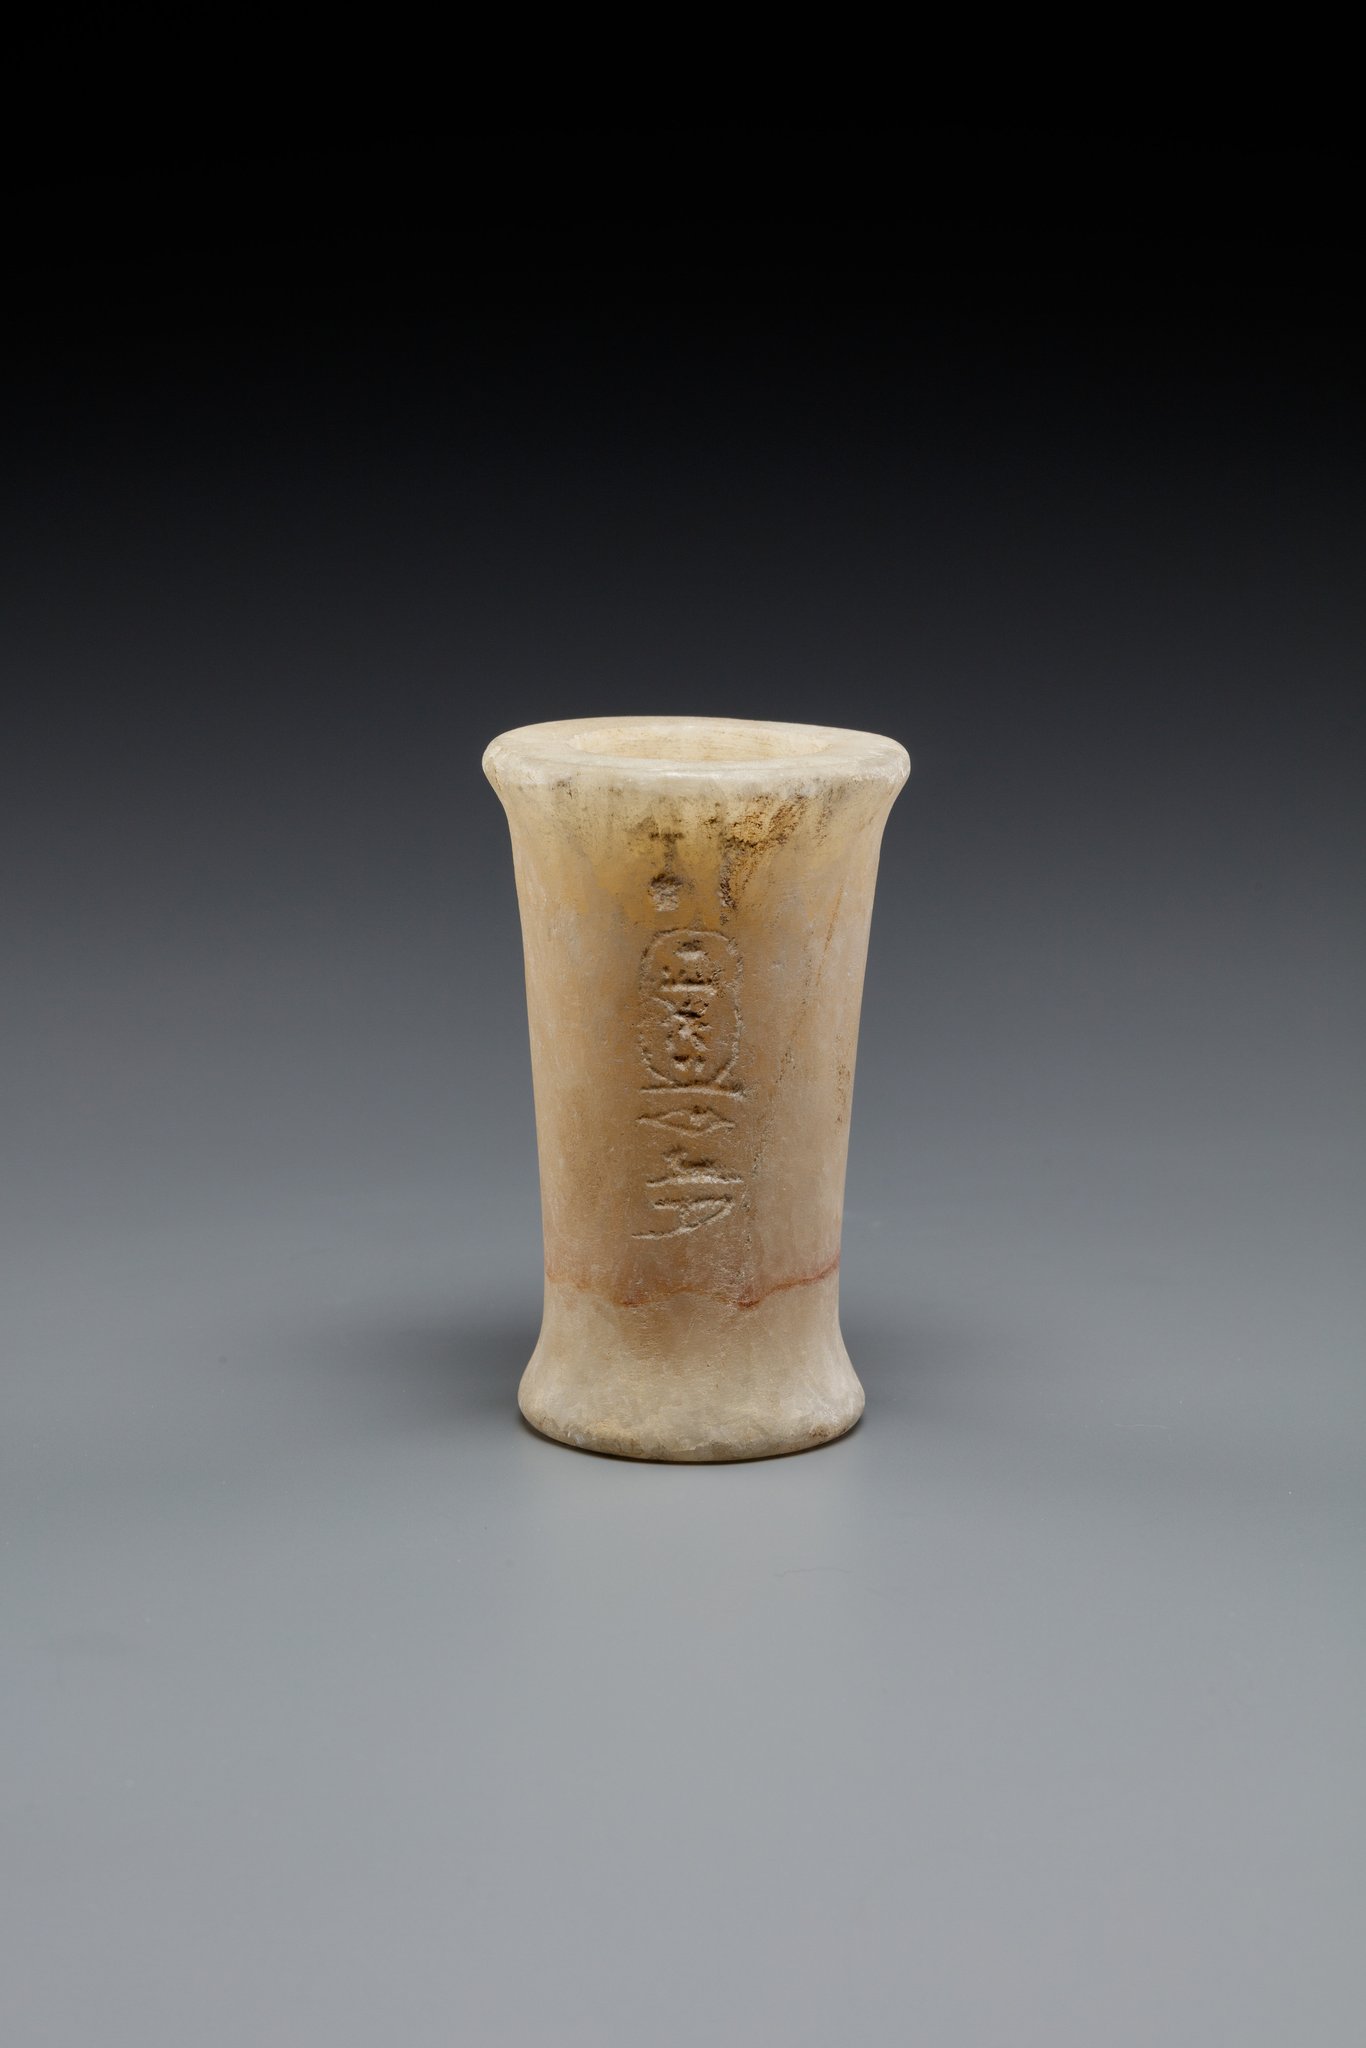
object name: model, vase, thutmose iv, kv 43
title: Model Vase from a Foundation Deposit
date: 1400-1390 BCE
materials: stone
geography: egypt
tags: cartouches